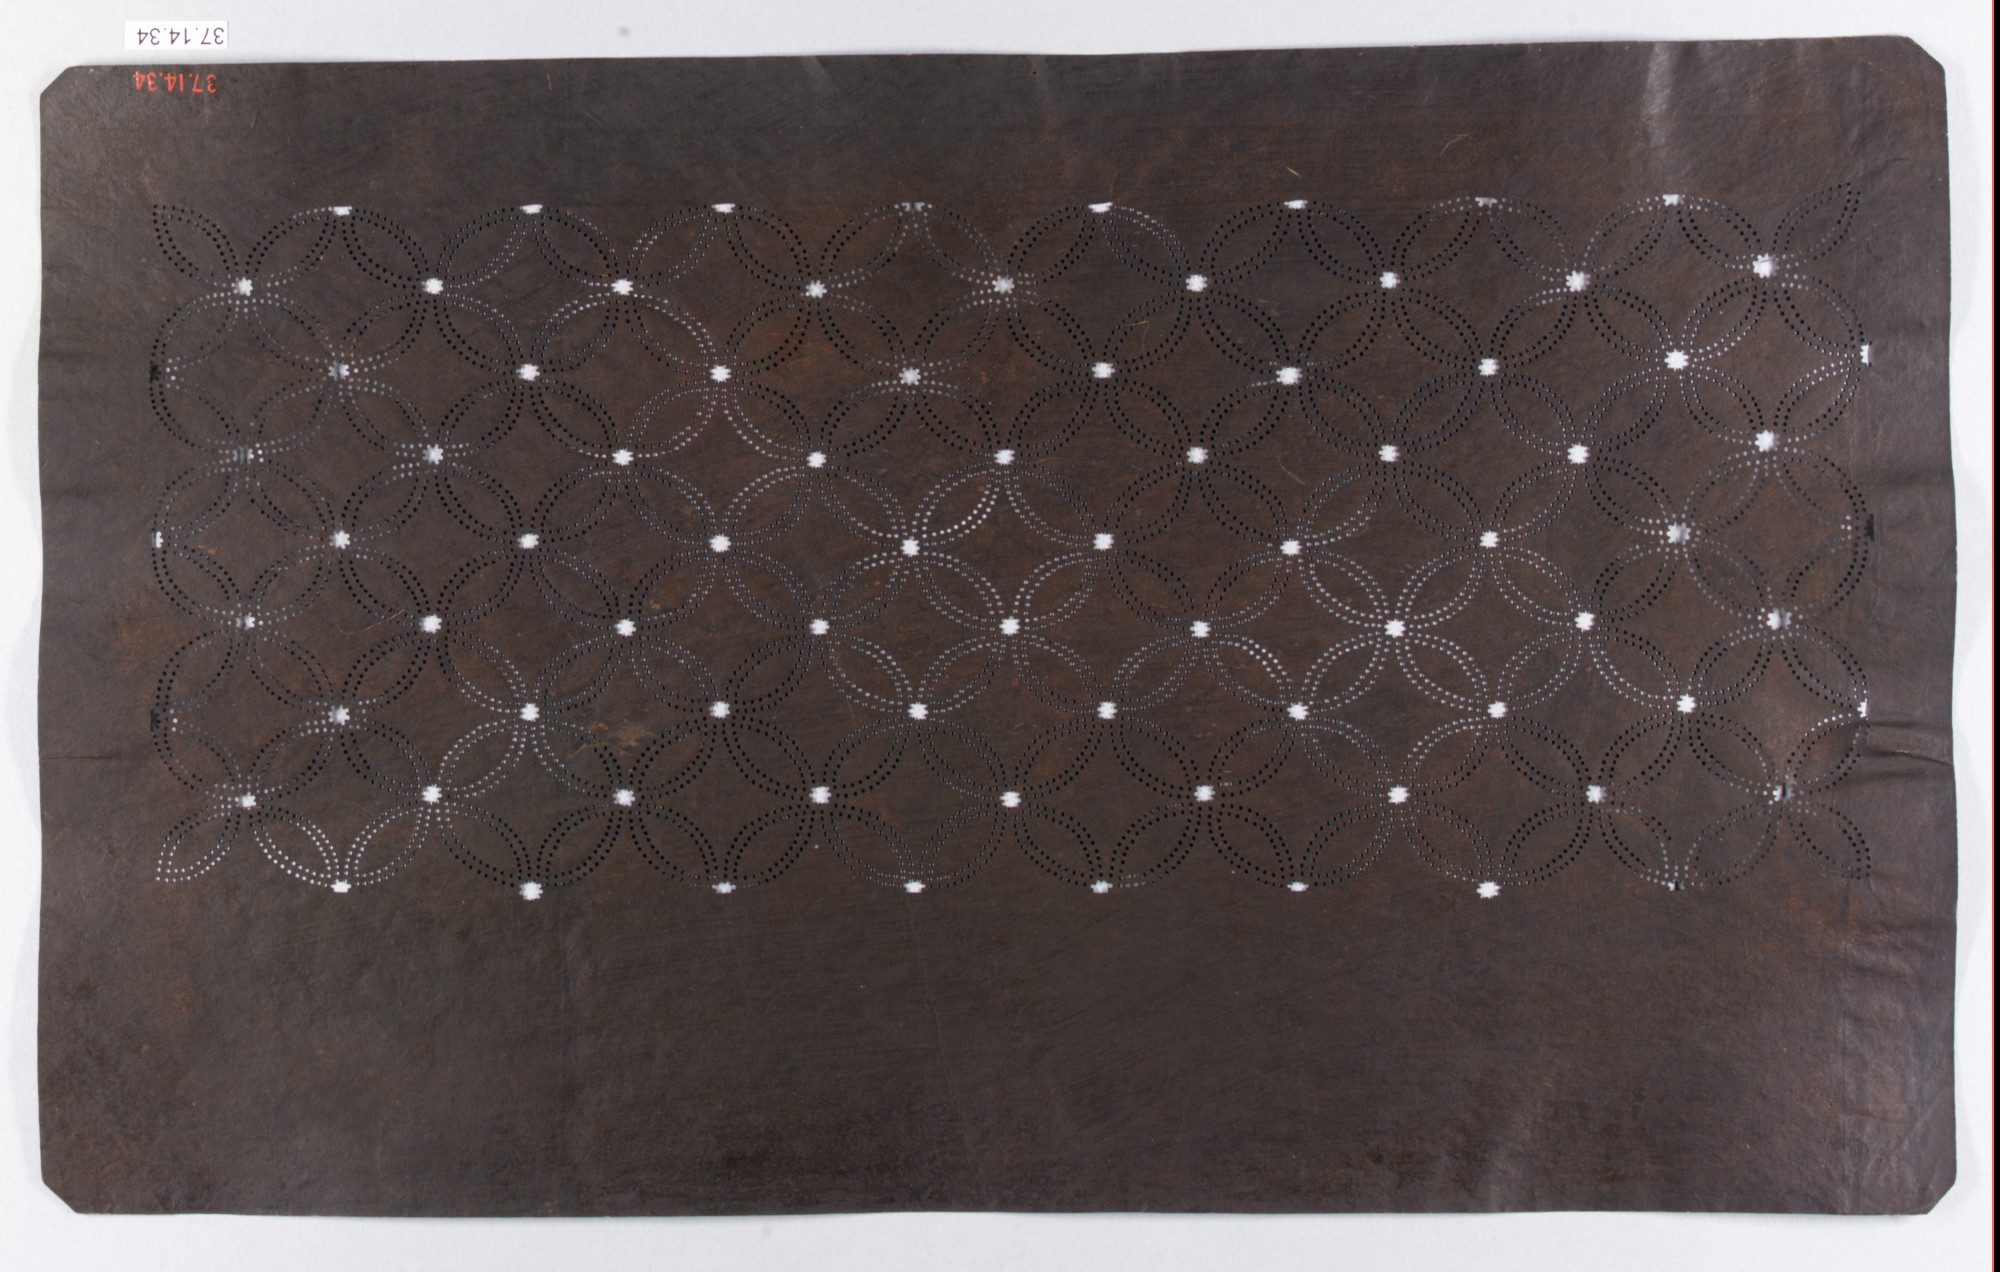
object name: stencil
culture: japanese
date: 1801-1833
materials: paper